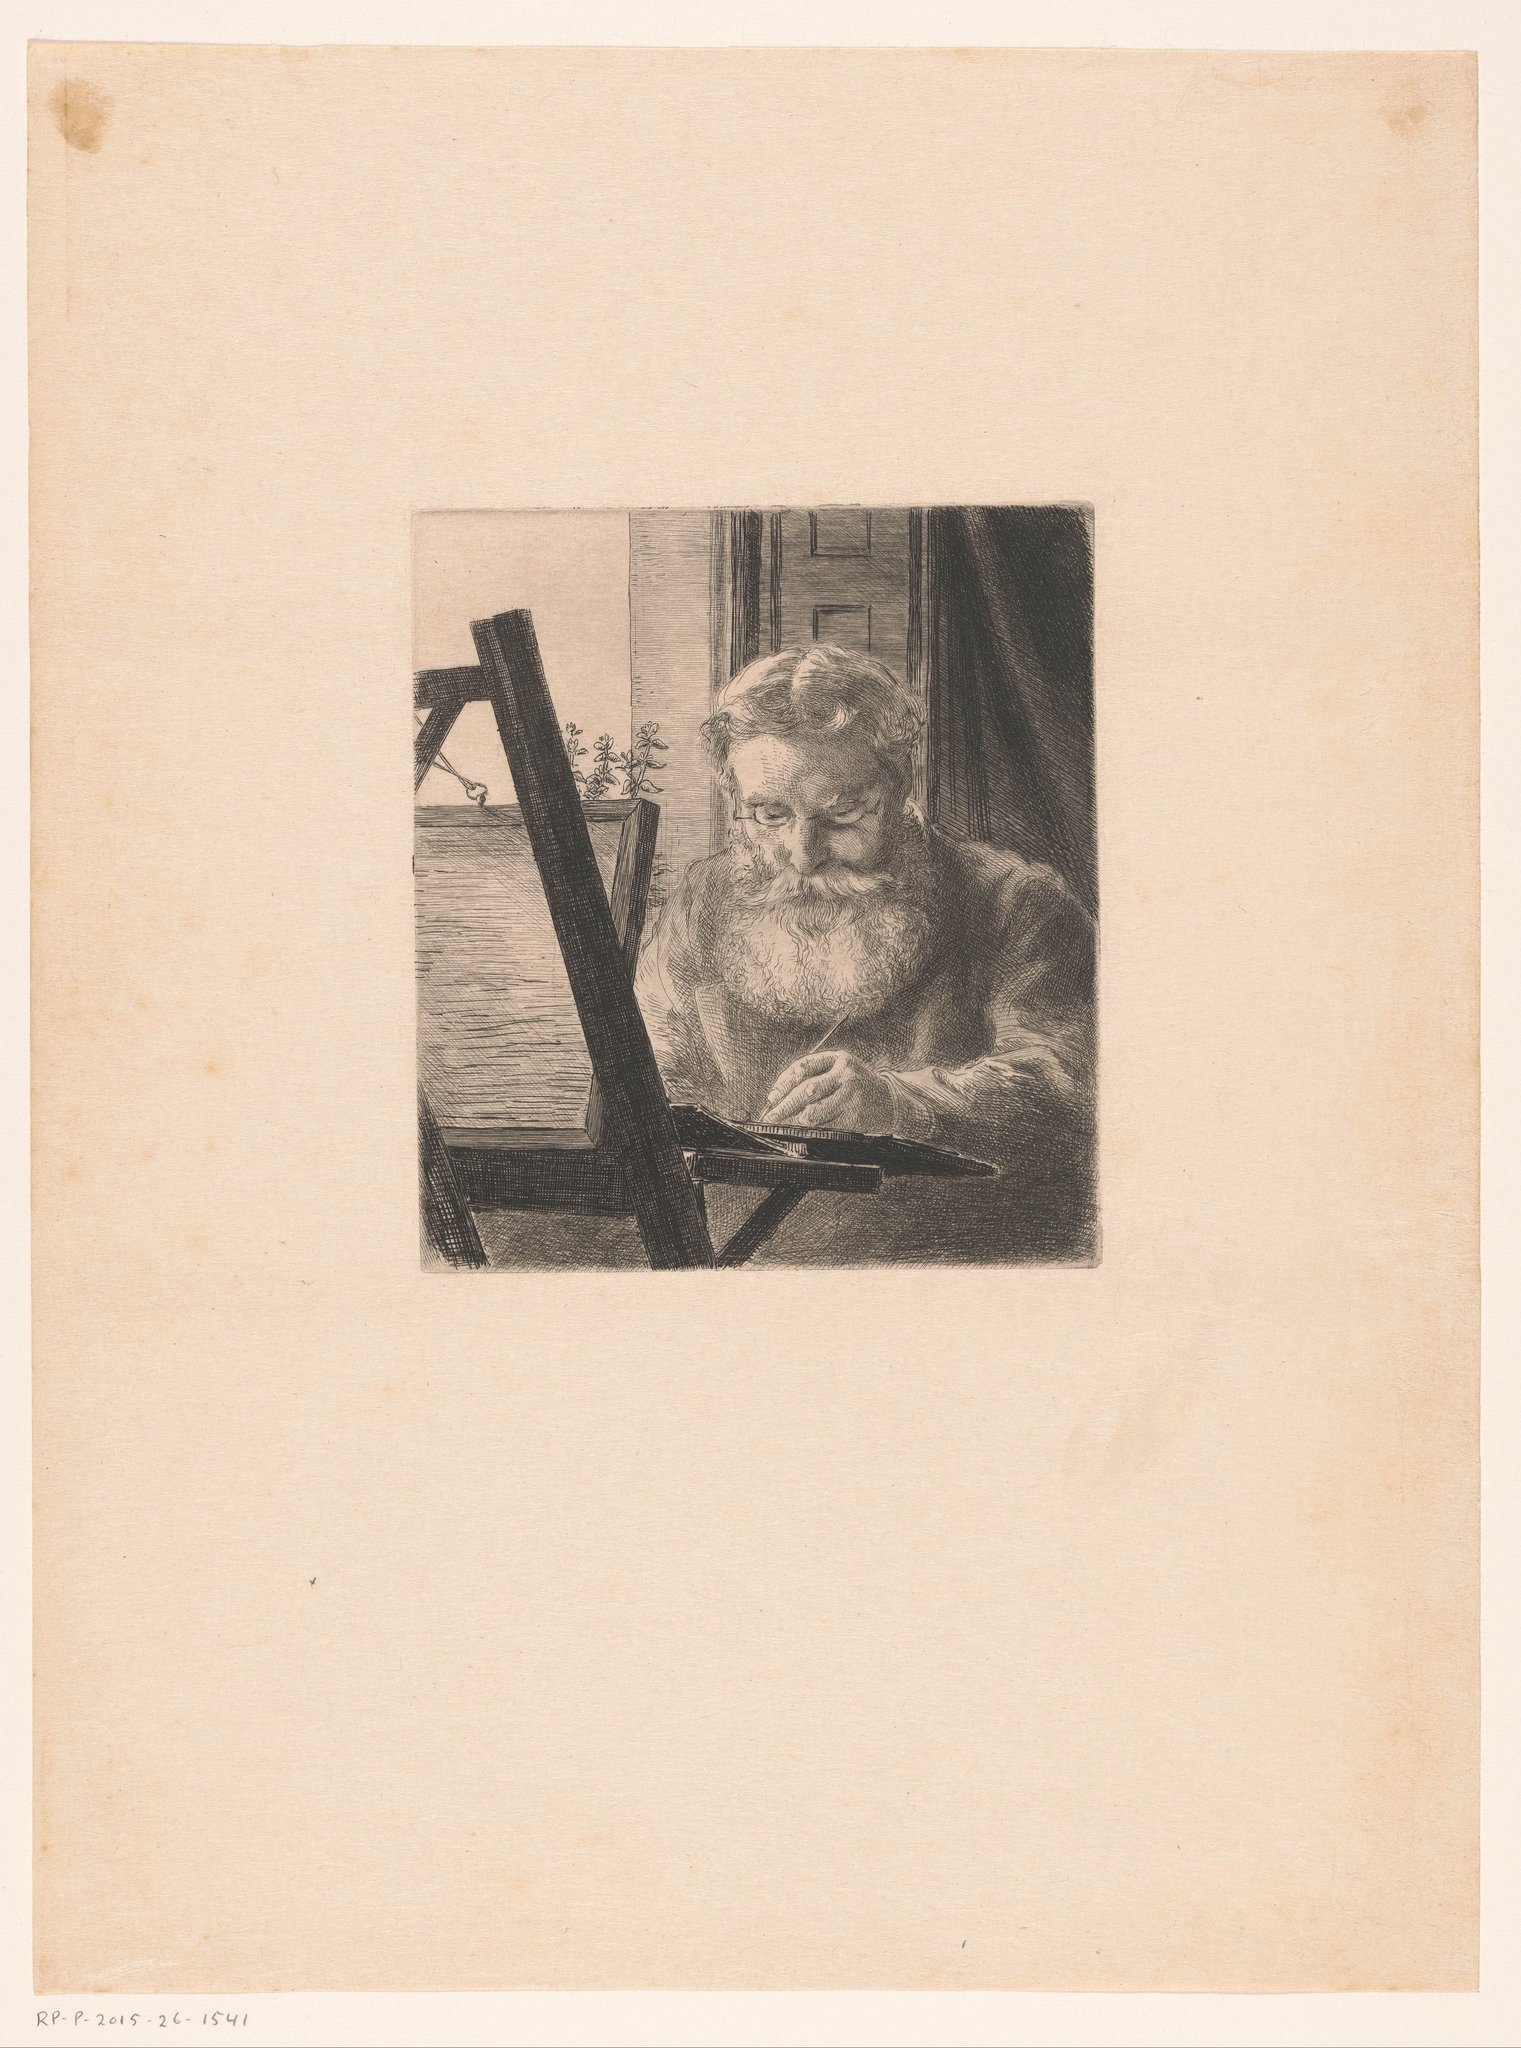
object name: print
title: Portret van kunstenaar Edwin Edwards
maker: félix bracquemond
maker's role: print maker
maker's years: 1833-1914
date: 1872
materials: paper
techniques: drypoint, etching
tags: london, print maker, edwin edwards, tools, implements of graphic artist, easel, artist at work, in his workshop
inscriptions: collector's mark: Lugt 4779, collector's mark: Lugt 2228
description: Portret van de Engelse kunstenaar Edwin Edwards aan het werk achter een ezel voor het raam. Hij draagt een bril en in zijn linkerhand heeft hij een etsnaald.